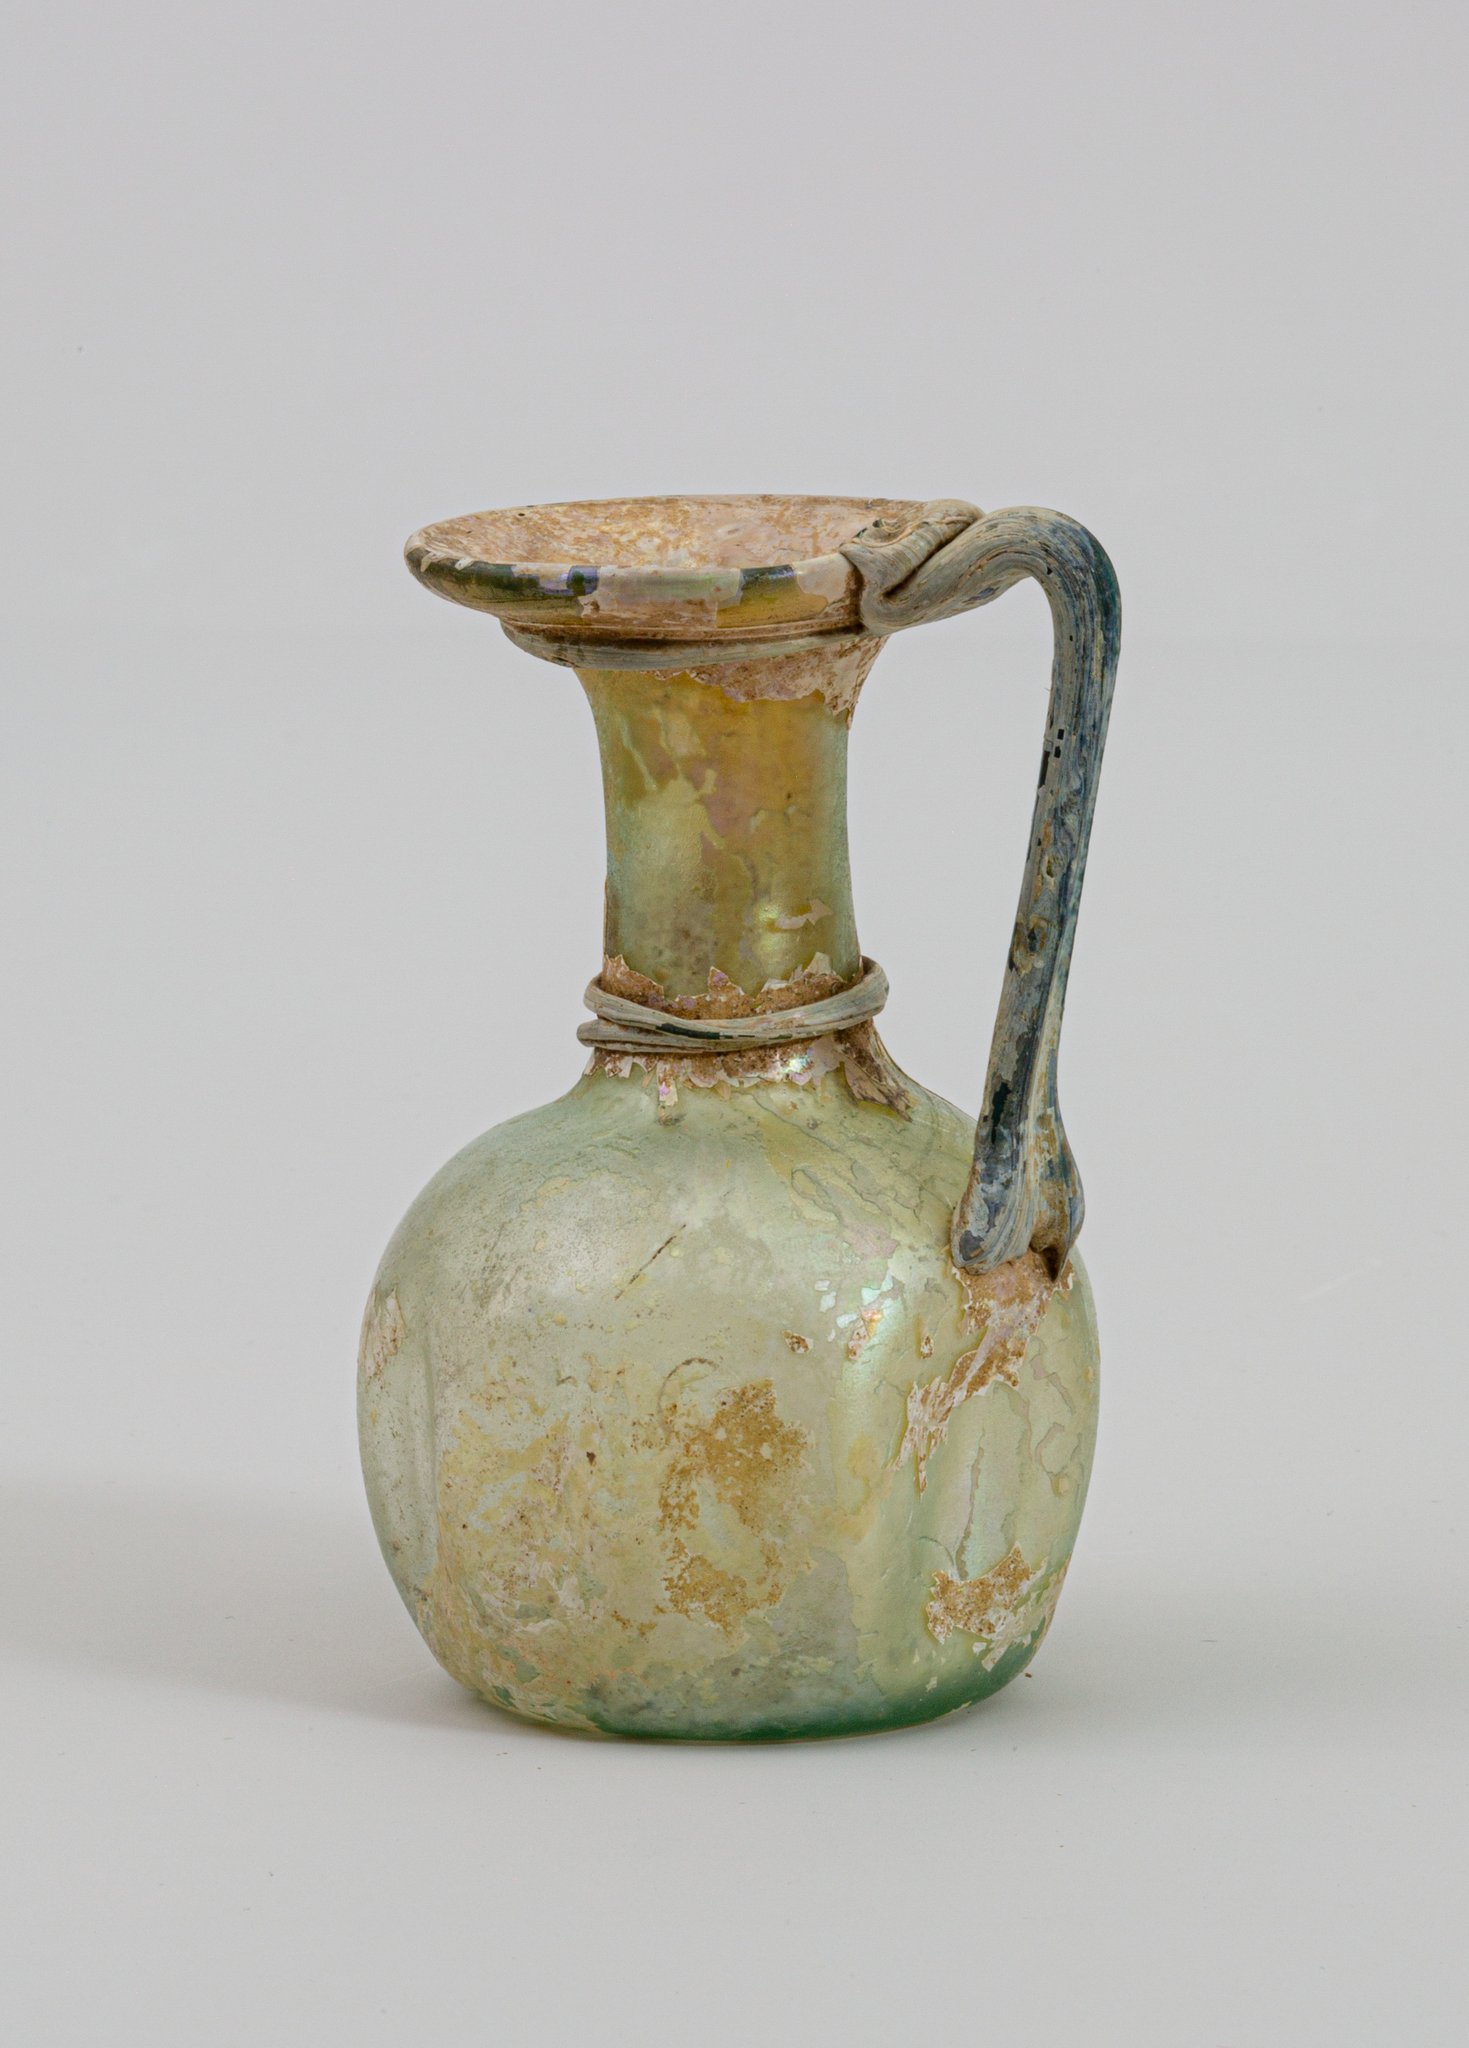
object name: jug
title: Glass indented jug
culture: roman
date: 301-500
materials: glass